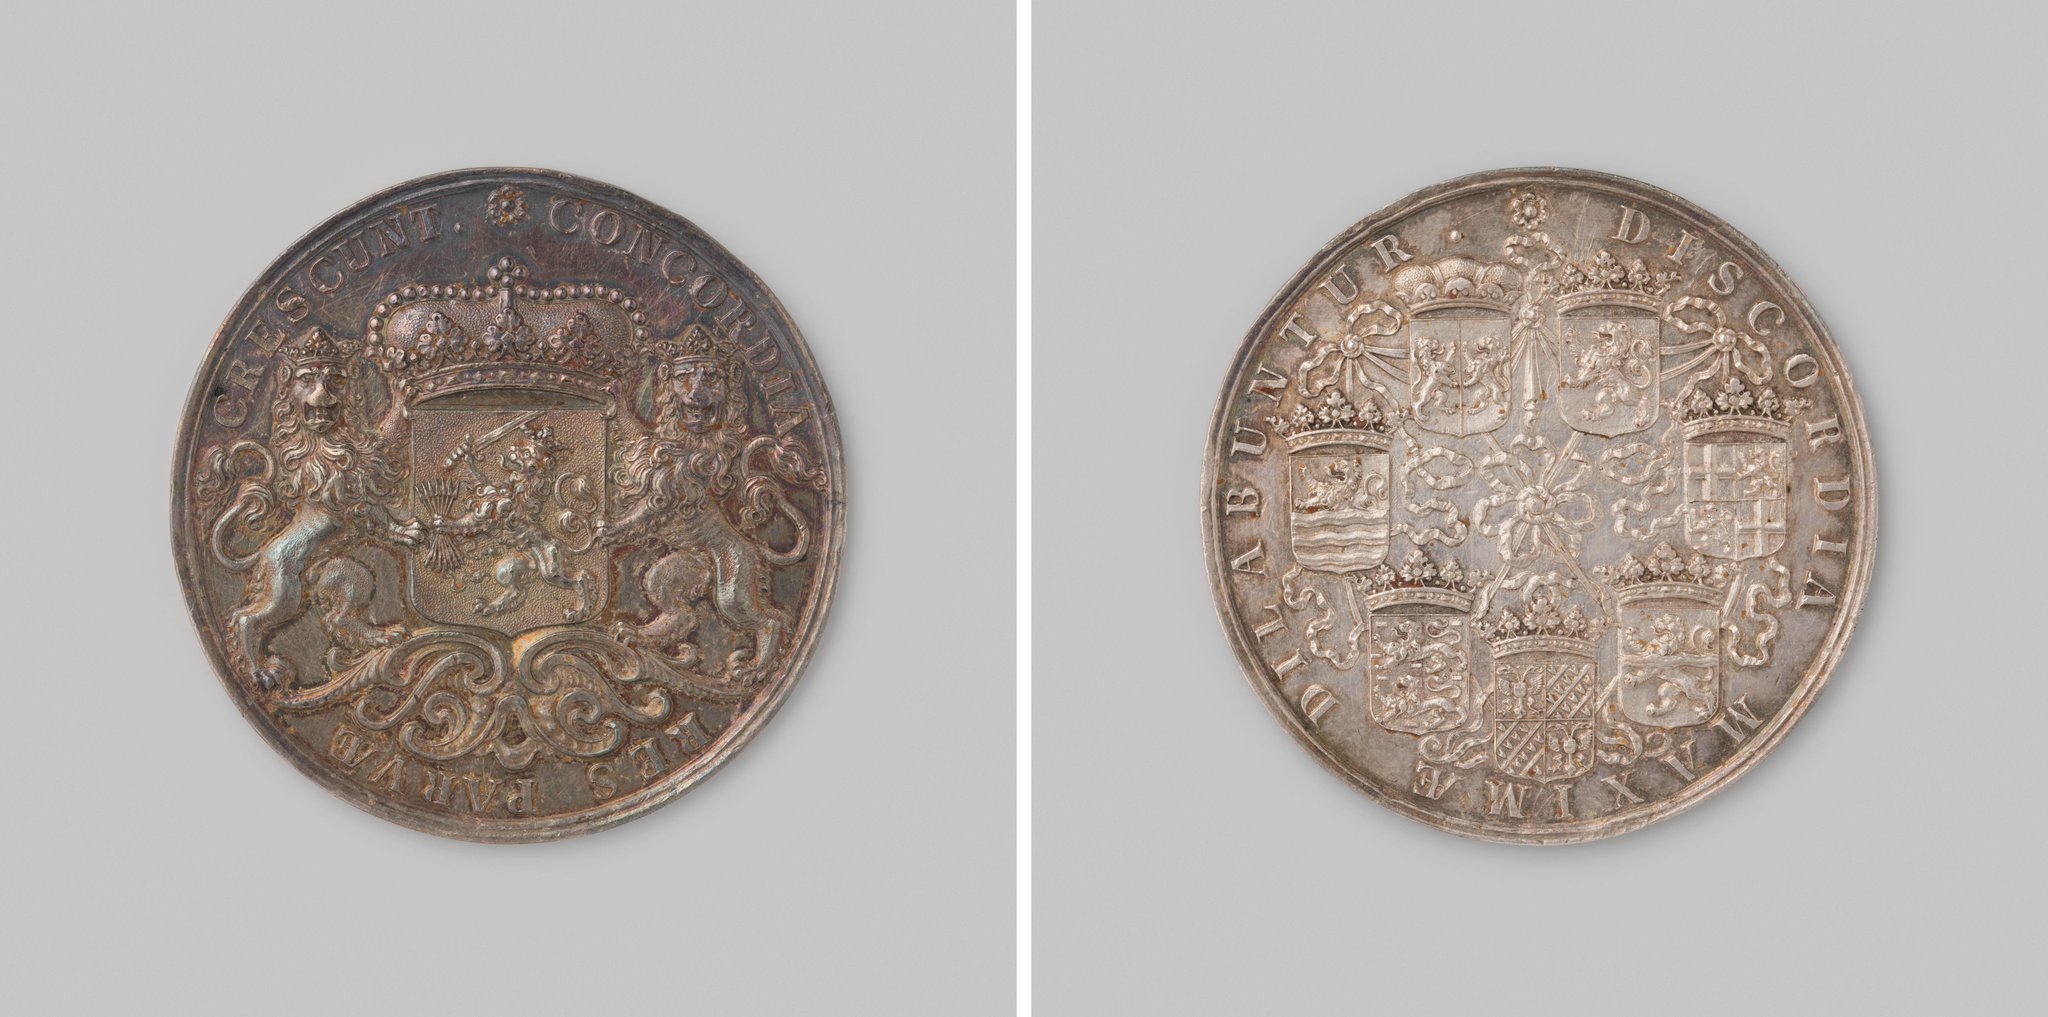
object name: history medal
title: Ambassadeurspenning 1609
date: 1609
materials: silver